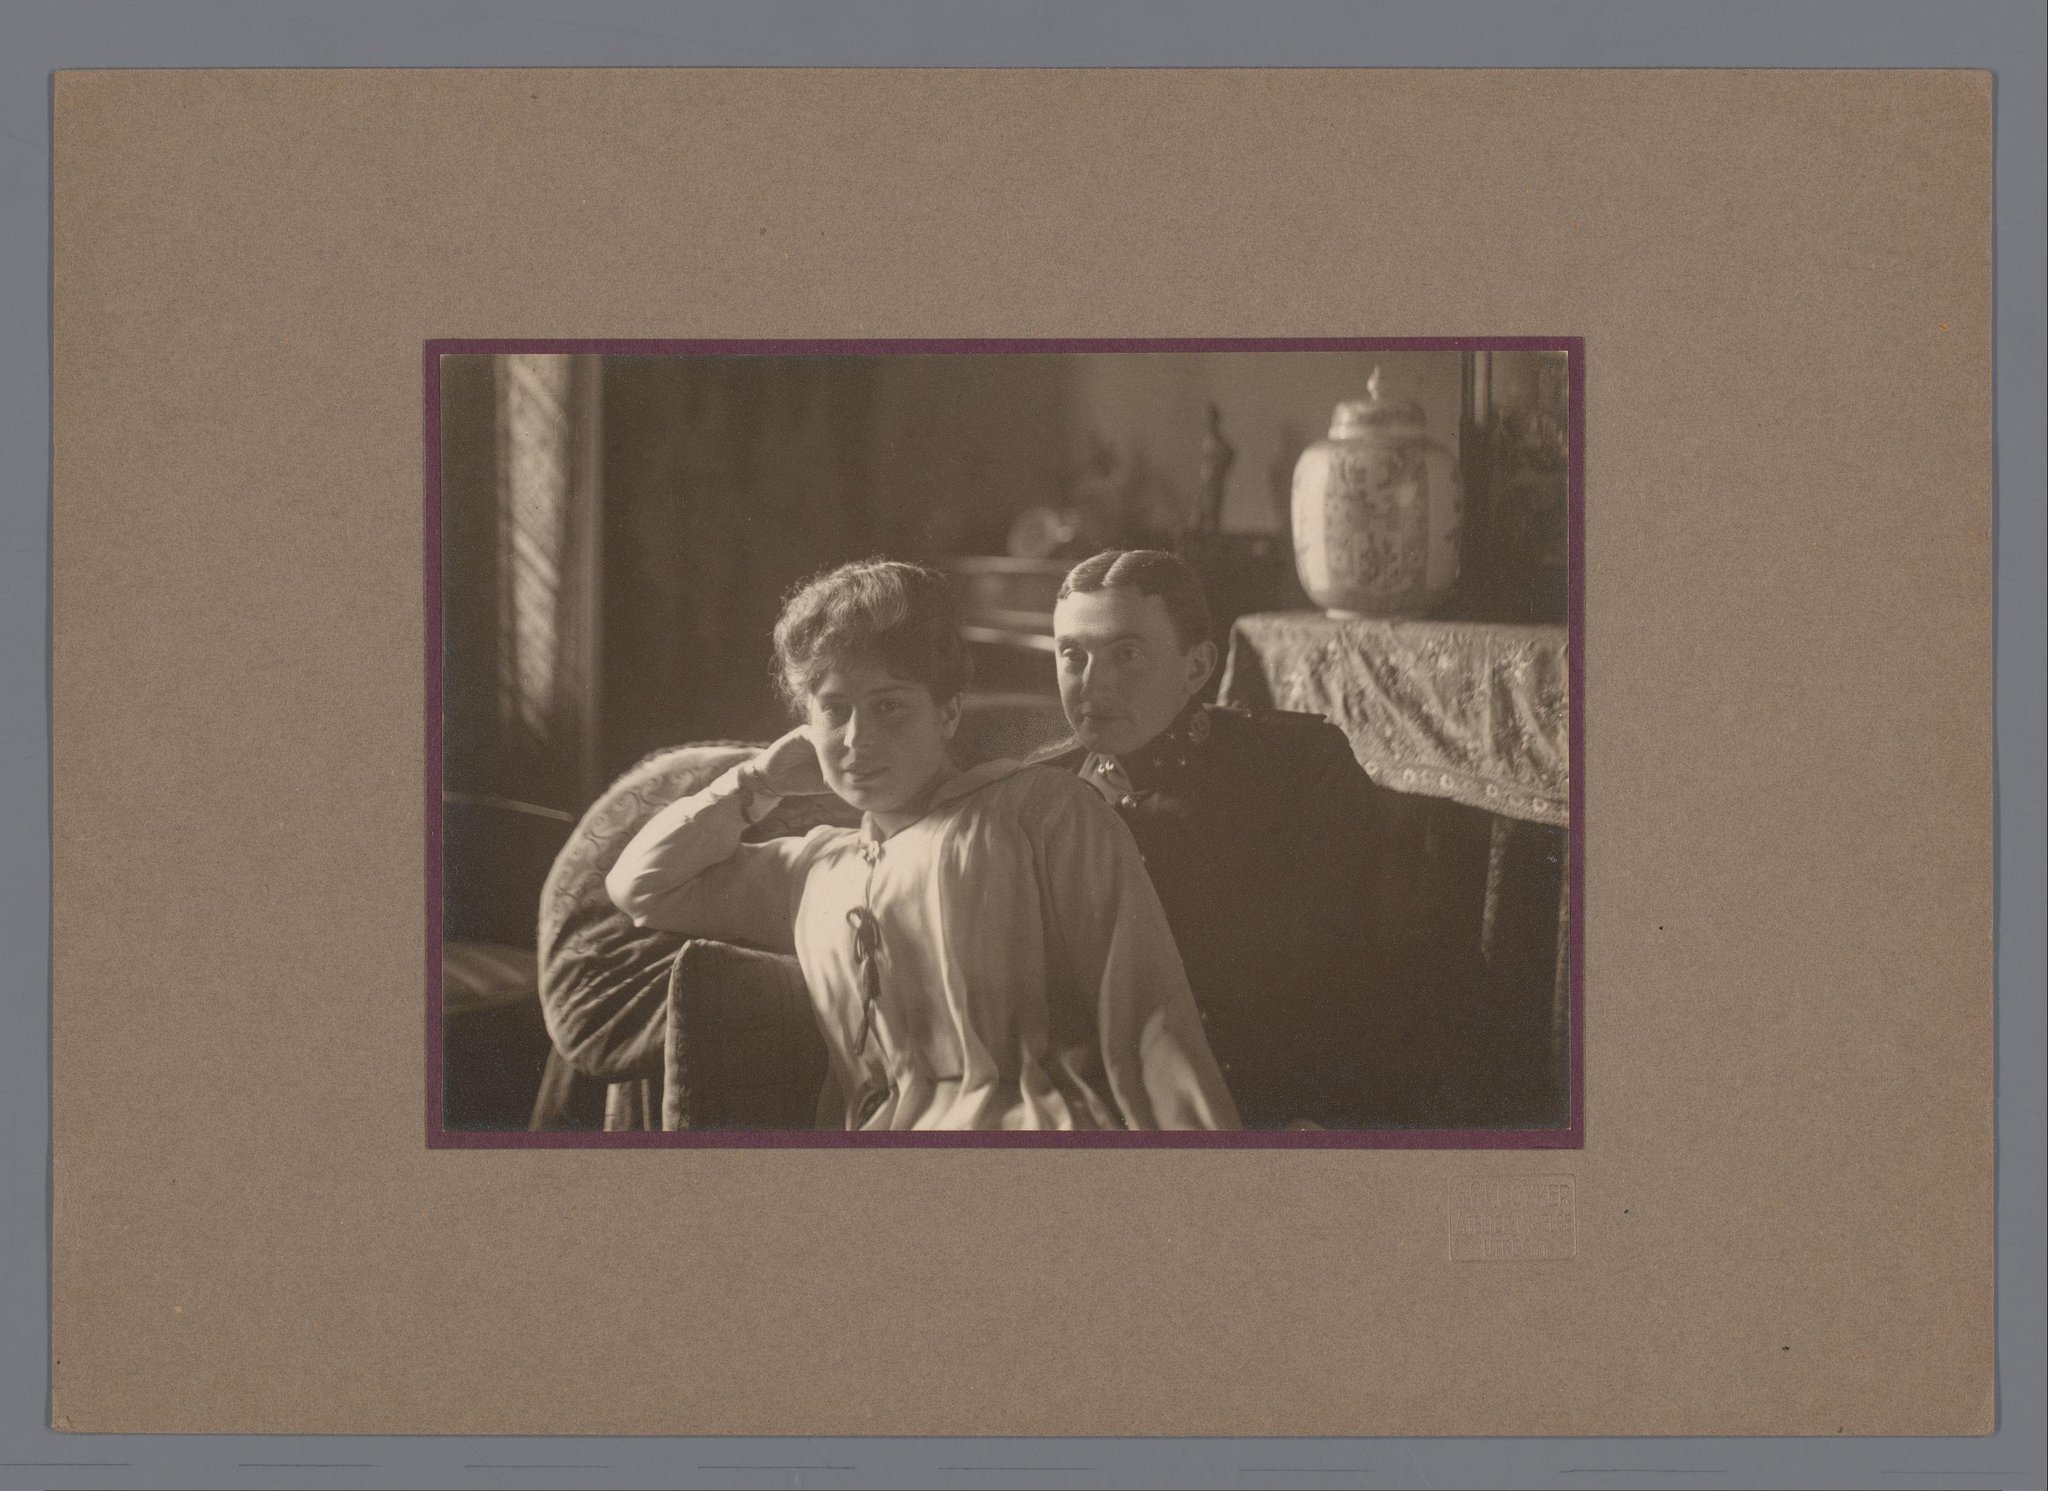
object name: photograph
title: Portret van een man en vrouw, op een bank, in interieur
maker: gerardus cornelis kooyker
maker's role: fotograaf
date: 1900-1920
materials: cardboard, photographic support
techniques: gelatin silver print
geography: utrecht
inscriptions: check stamp: ‘G.C.KOOYKER//ATELIER INGELSE//UTRECHT’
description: Portret van man en vrouw (zittend)in een woonkamer/studio, een opvallende chinese siervaas op de achtergrond. Gat en afdruk van punaise in karton, midden boven. Foto op klein paars karton dan op bruin karton gelijmd. Vergelijk met foto RP-F-00-6018:dezelfde man en vrouw.